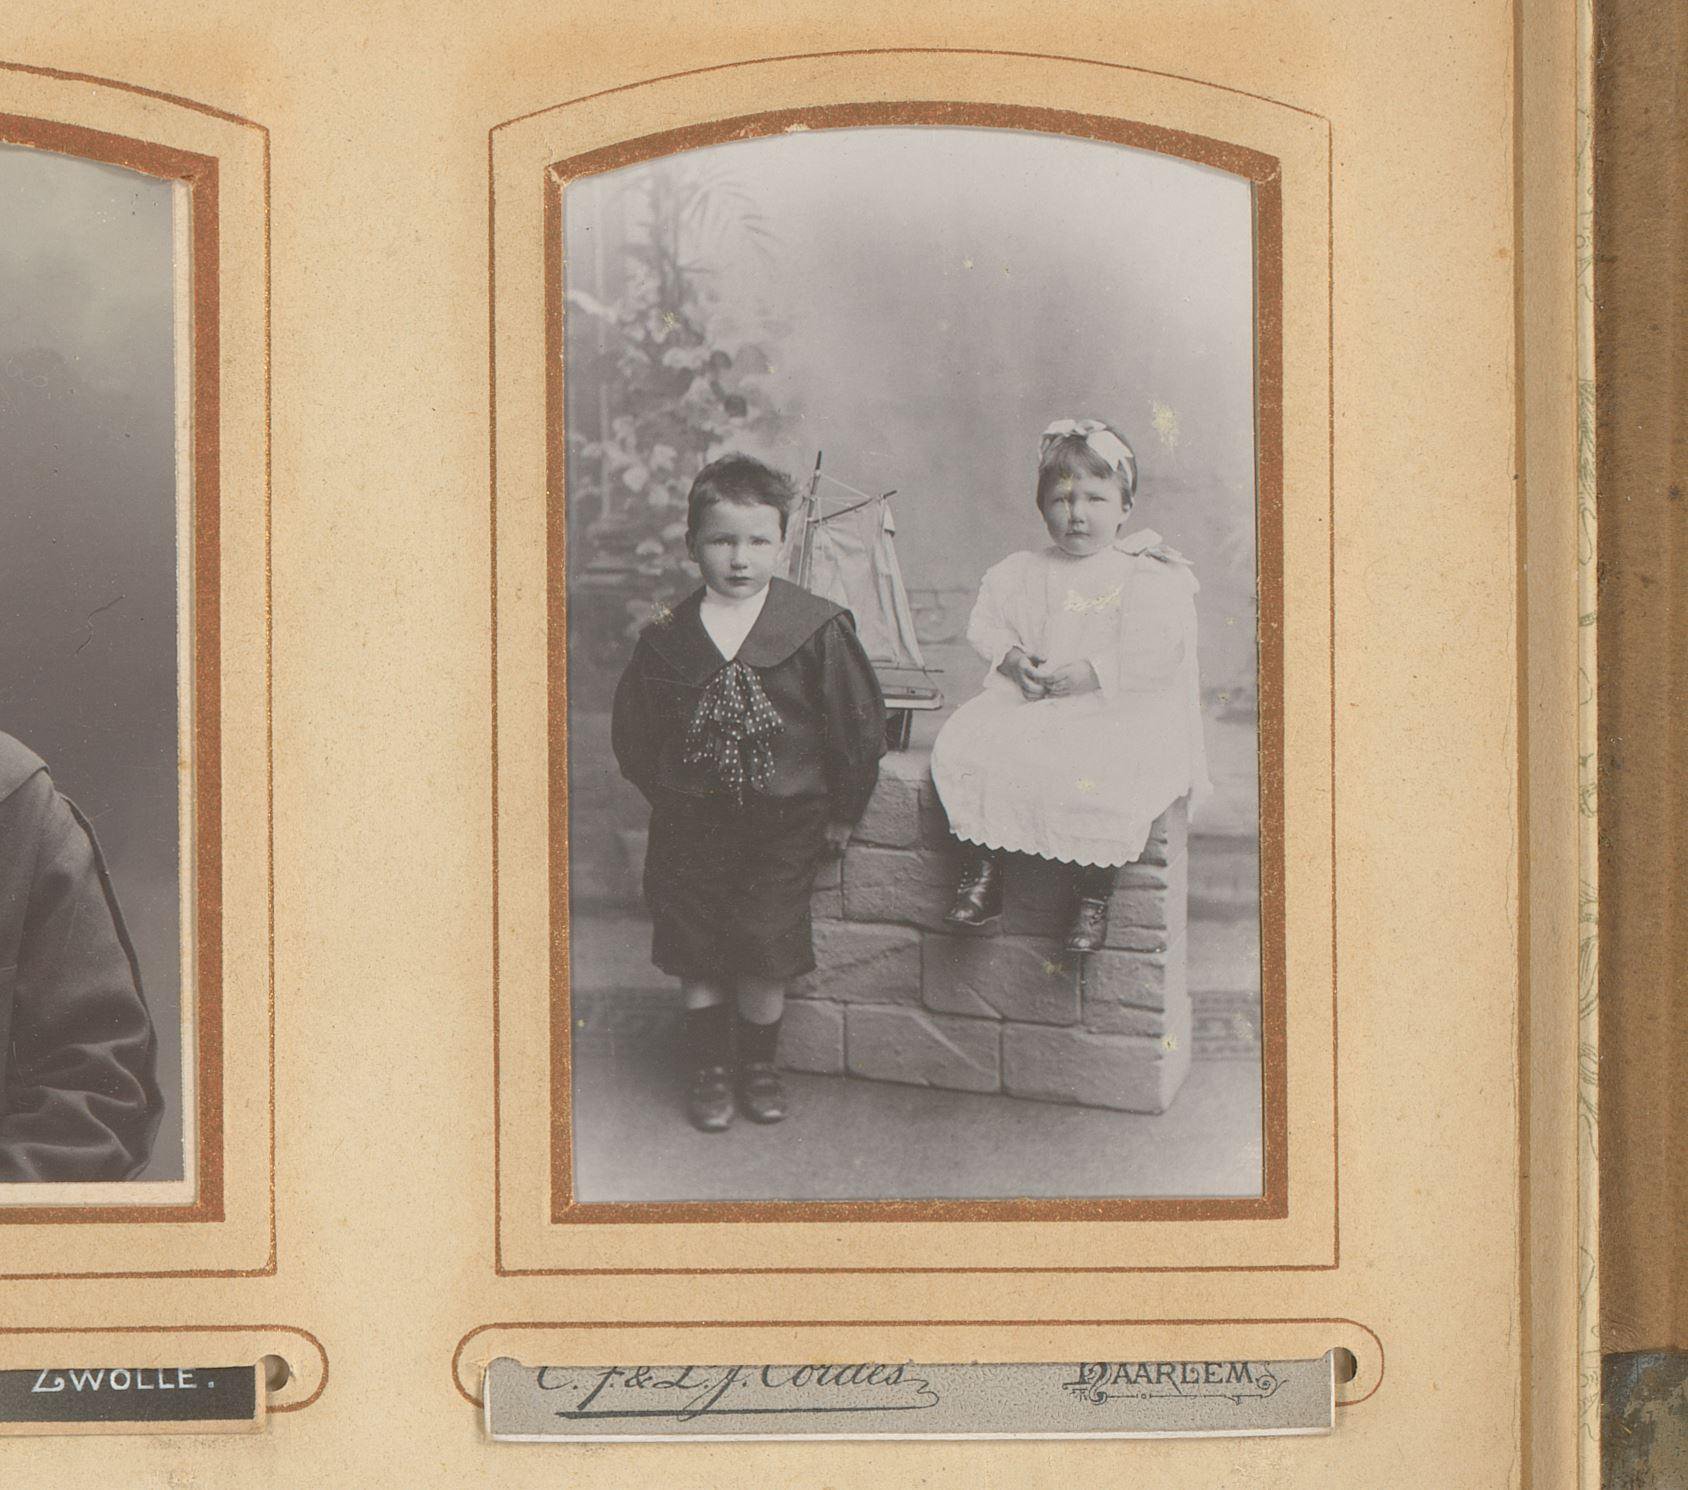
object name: photograph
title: Portret van een jongen en meisje, aangeduid als Aatje en Liesje v. Son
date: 1902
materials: cardboard, photographic support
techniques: collodion silver print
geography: haarlem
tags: boy (child between toddler and youth), girl (child between toddler and youth)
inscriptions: inscription: ‘C.F & L.J. Cordes/ Haarlem’, annotation: ‘Aatje en Liesje v. Son/ 17 juli 1902’